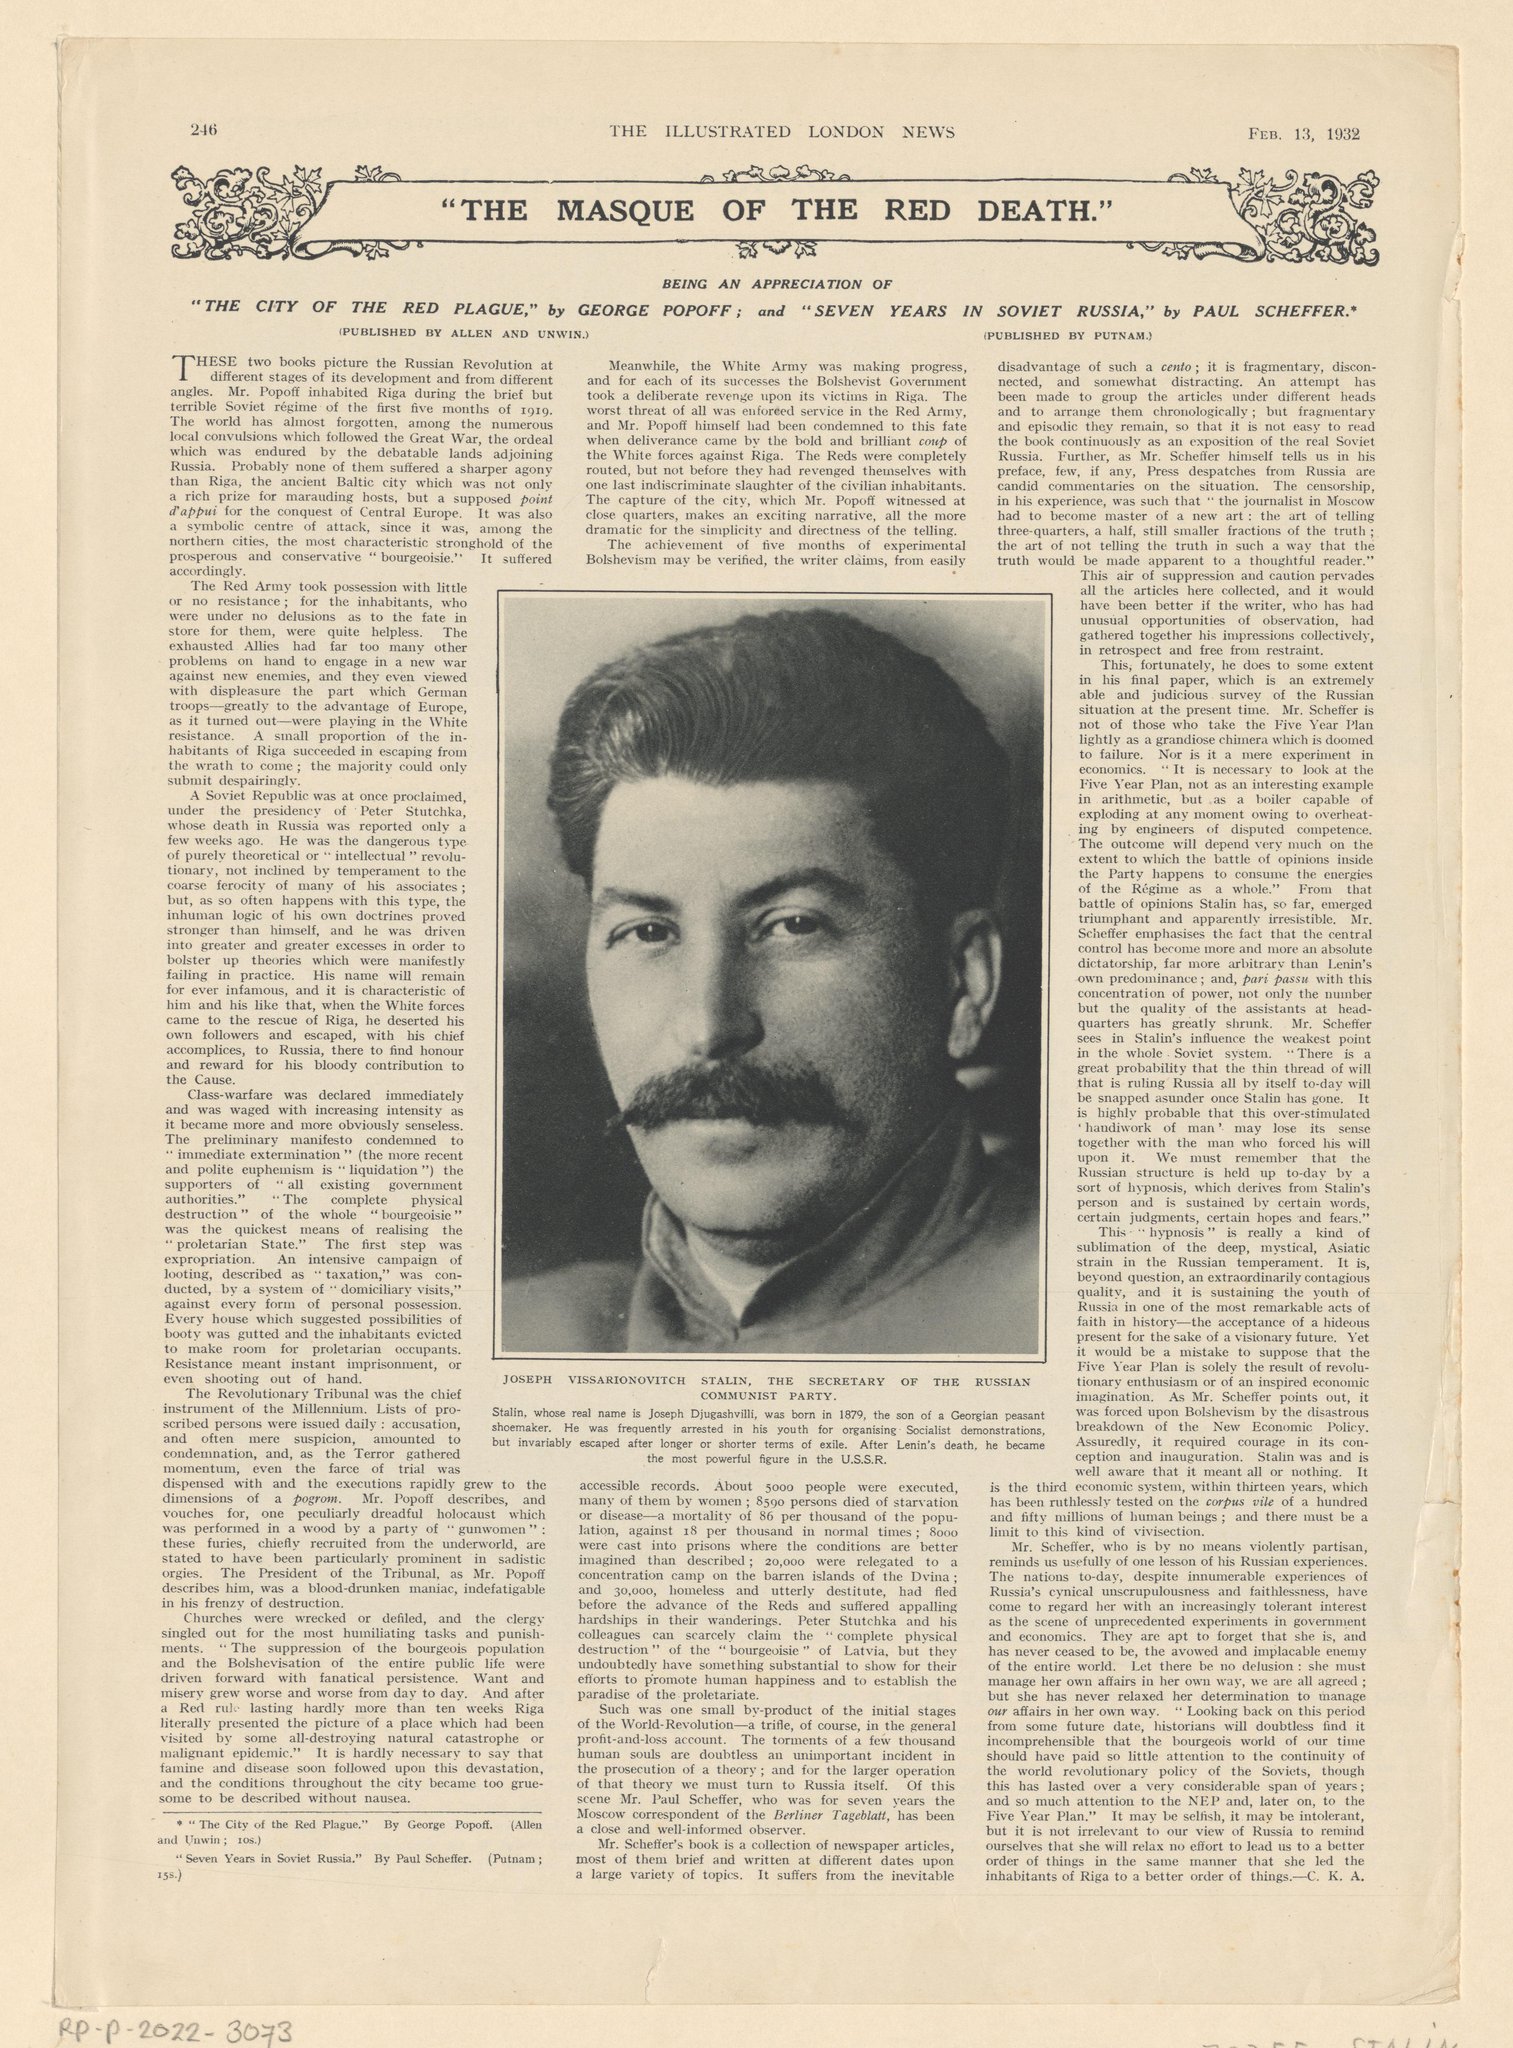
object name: photomechanical print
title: Portret van Joseph Stalin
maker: Anonymous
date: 1932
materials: paper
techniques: letterpress printing, rotogravure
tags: historical persons, politician, e.g. party leader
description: Fotomechanische afdruk uit: The Illustrated London News (1932), 13 februari 1932.